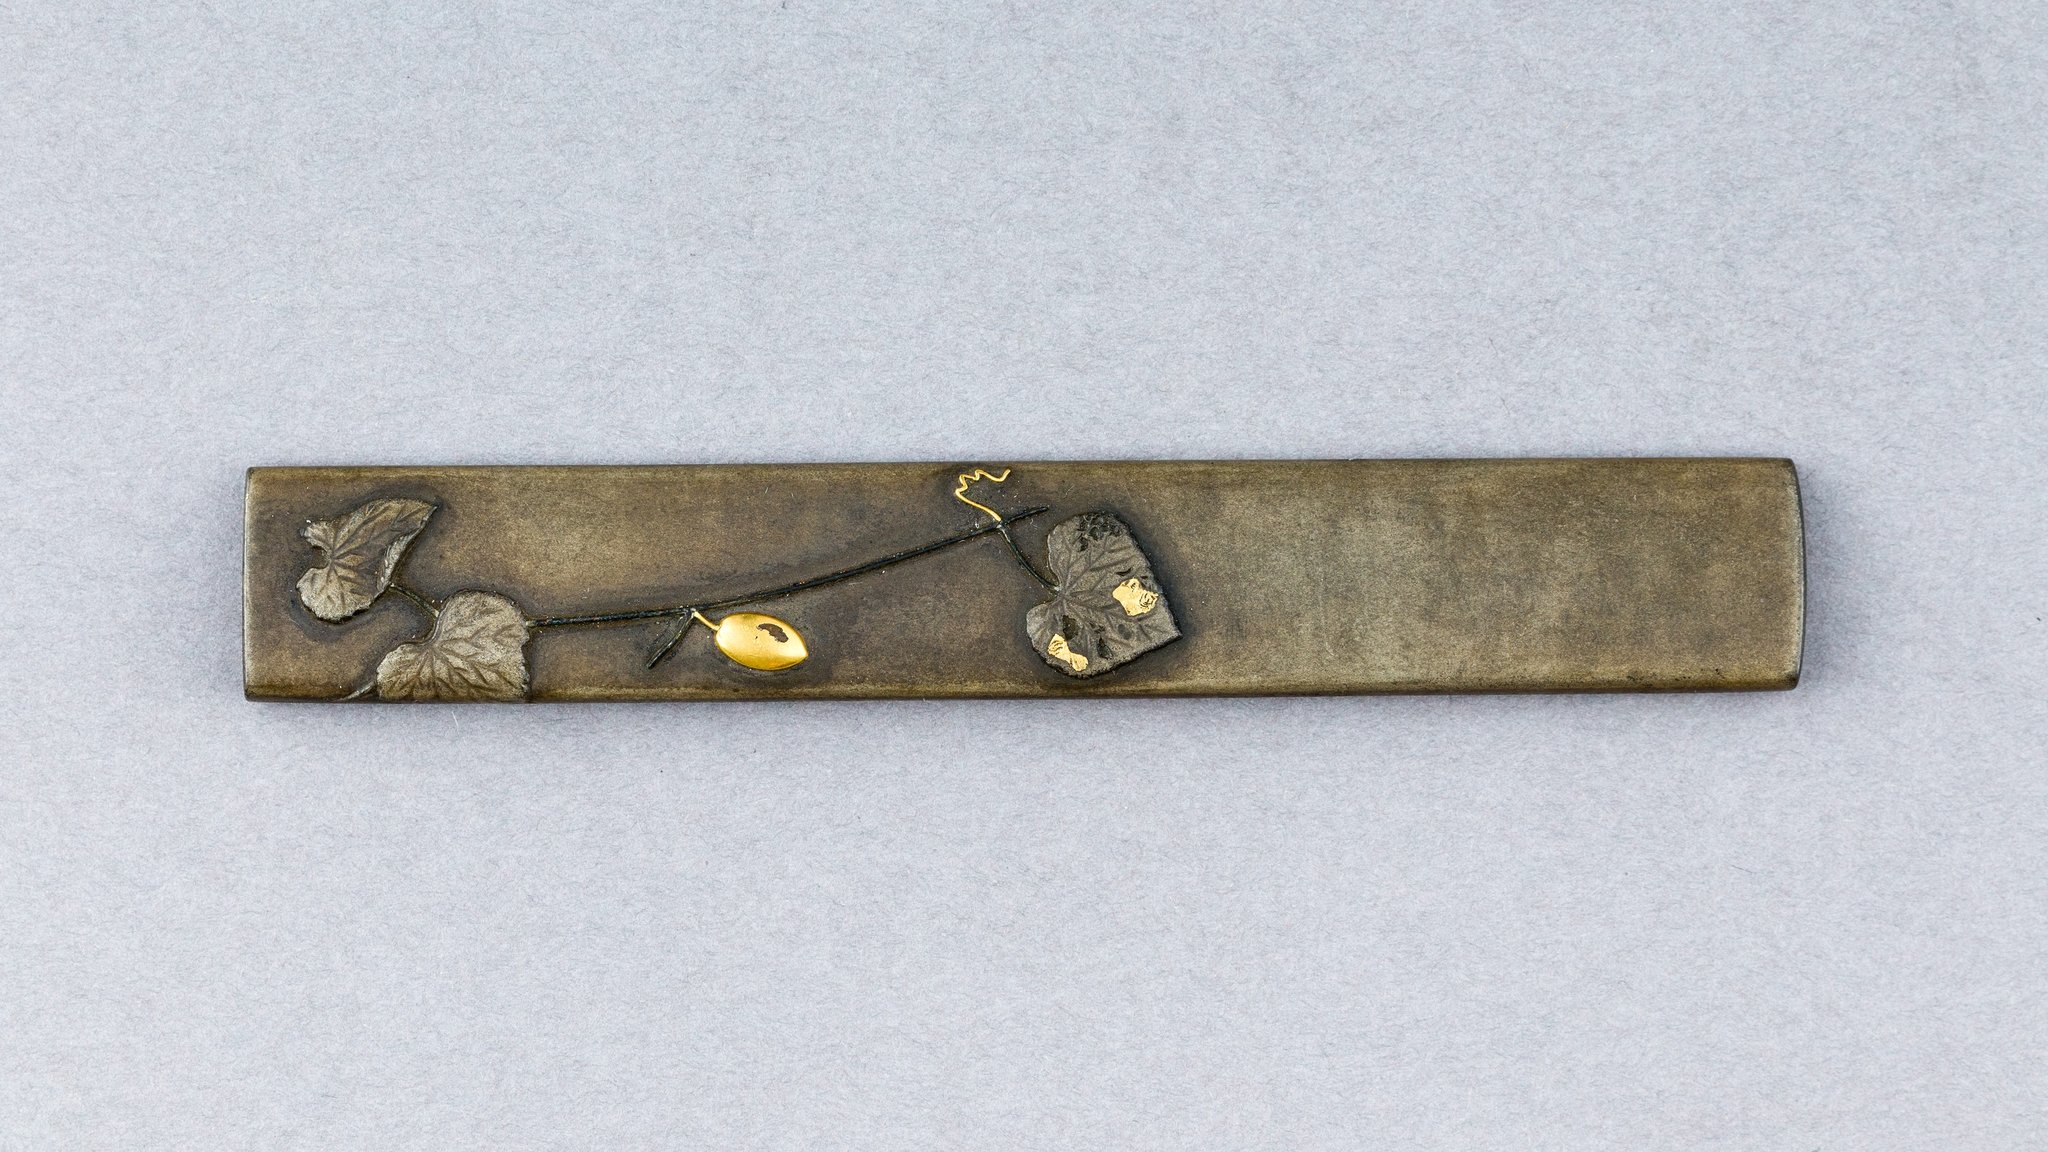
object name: knife handle kozuka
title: Knife Handle (Kozuka)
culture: japanese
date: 1615-1868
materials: silver alloy, gold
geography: japan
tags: leaves